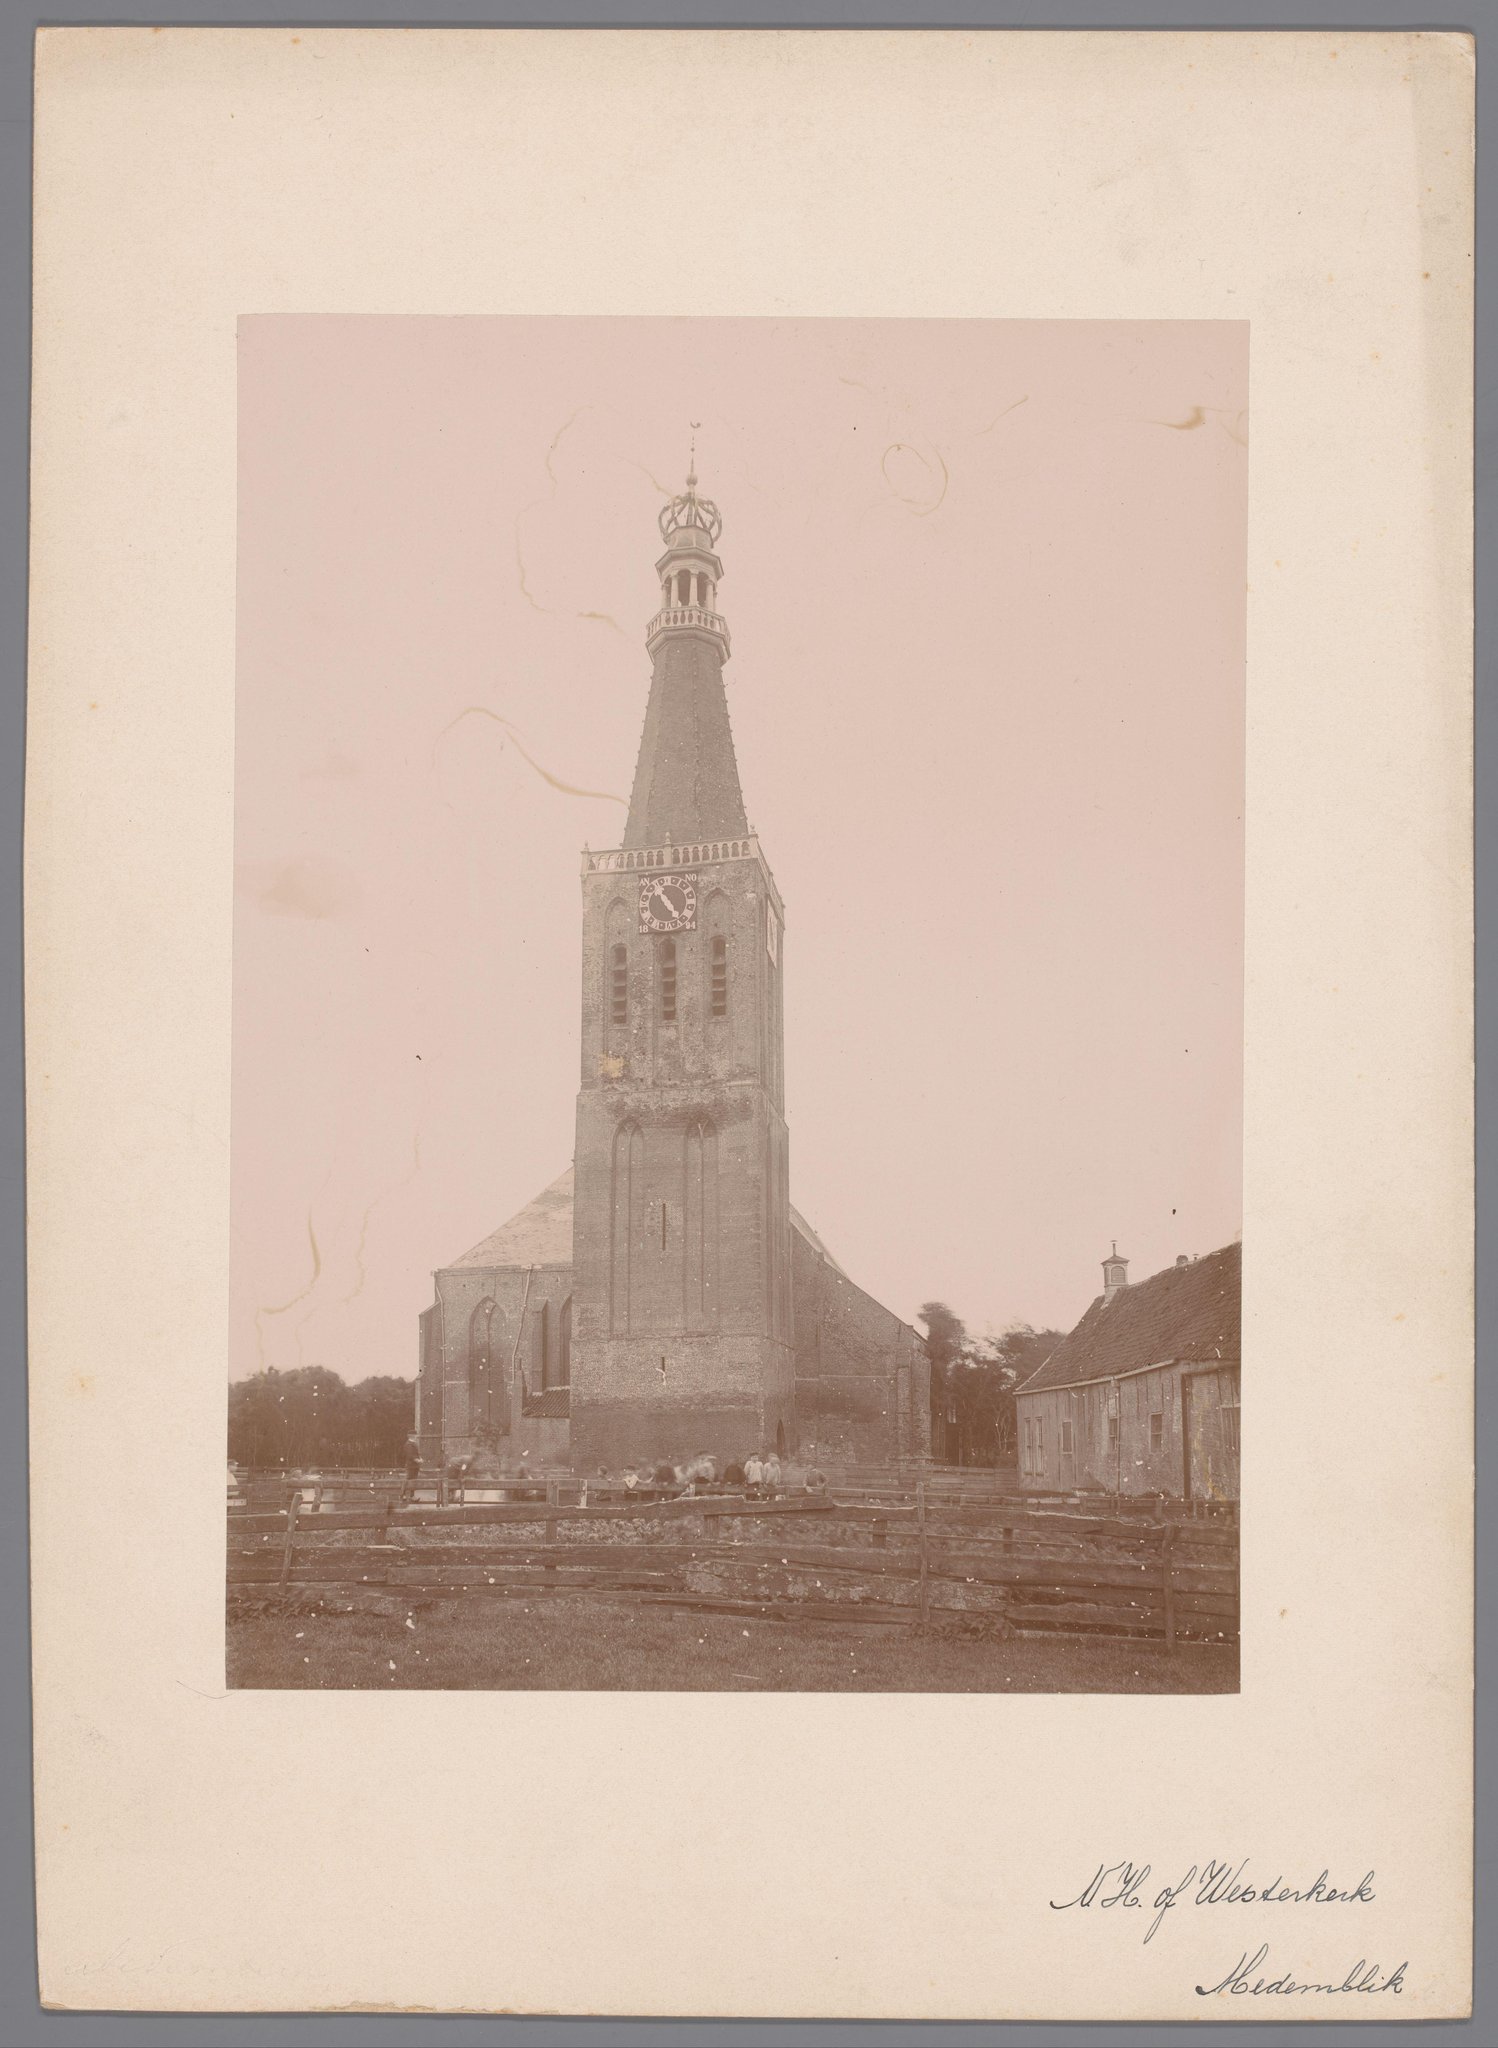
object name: photograph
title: Gezicht op de Westerkerk te Medemblik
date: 1898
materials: cardboard, photographic support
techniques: gelatin silver print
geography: medemblik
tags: church (exterior)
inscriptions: annotation: ‘Toren v/d Ned. Herv. Kerk te Medemblik (N.H.)/ Juli 1898’, annotation: ‘N.H. of Westerkerk/ Medemblik’